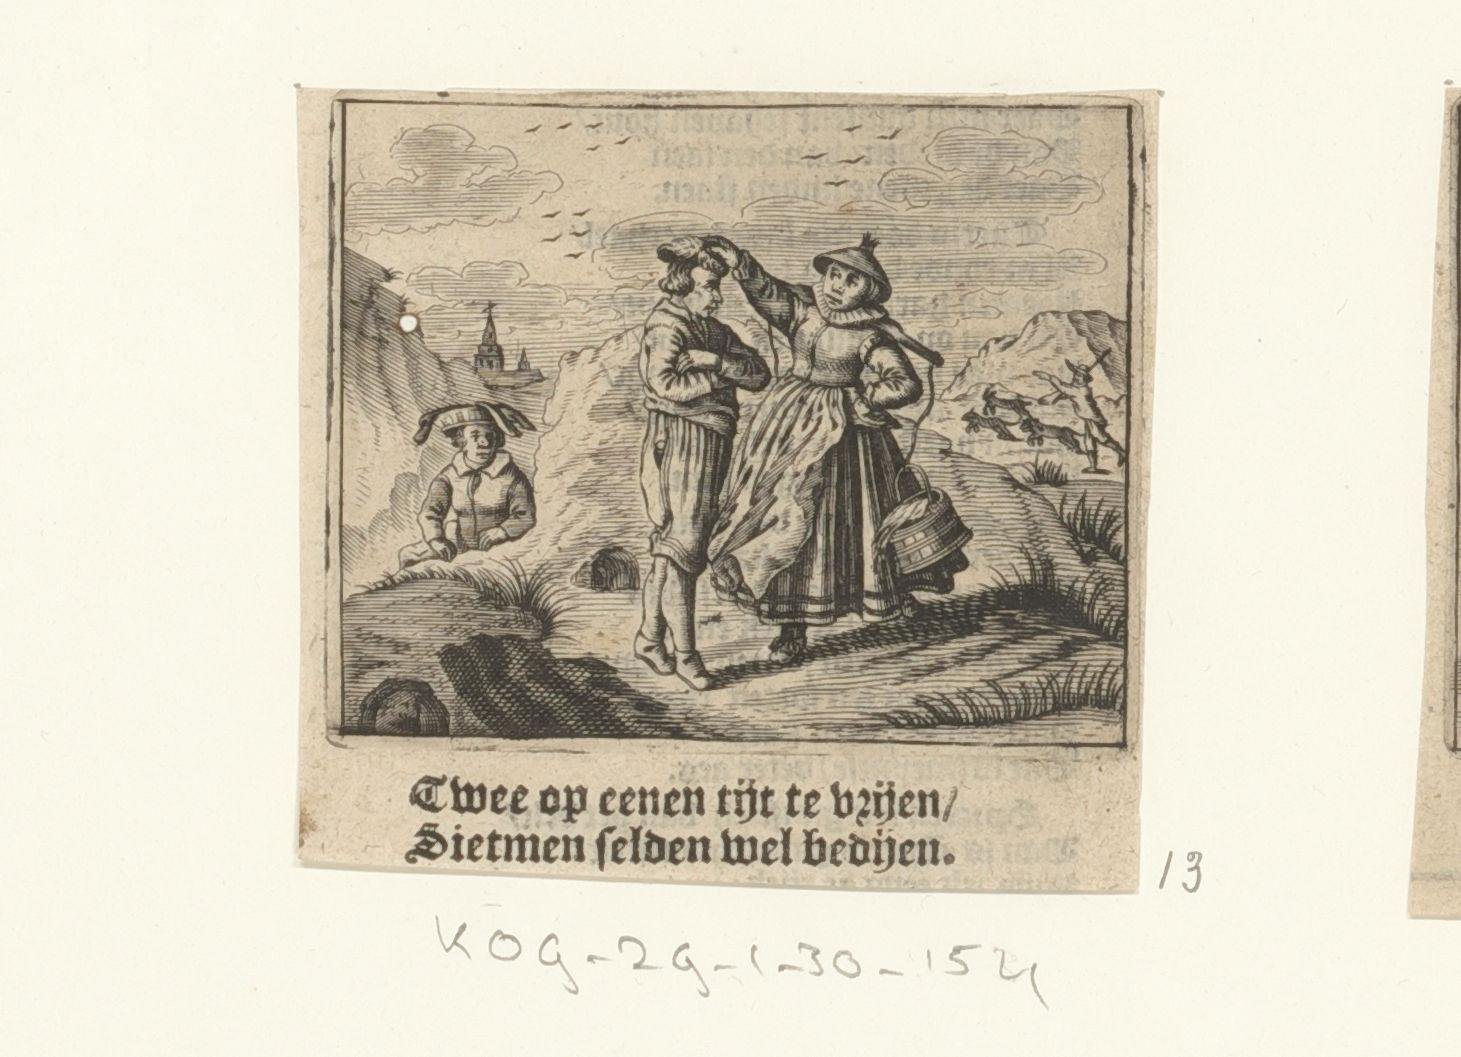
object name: print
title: Vrouw met juk aait man over zijn hoofd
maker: Anonymous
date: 1635-1715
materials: paper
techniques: engraving, letterpress printing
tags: proverbs, sayings, etc., rock-formations, lovers spied upon, yoke, couple of lovers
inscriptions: stamp, collector's mark: Lugt 1641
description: Vrouw met juk aait man over zijn hoofd, terwijl een andere man zich achter de rotsen verschuilt. Onderwerpsrubrieken binnen de Atlas Zeden en Gewoonten: Zeden en Gewoonten in engeren zin. Volksleven. Zinnebeeldige voorstellingen uit het volkleven op serieprenten. Maanden en diversen (allegorieën).